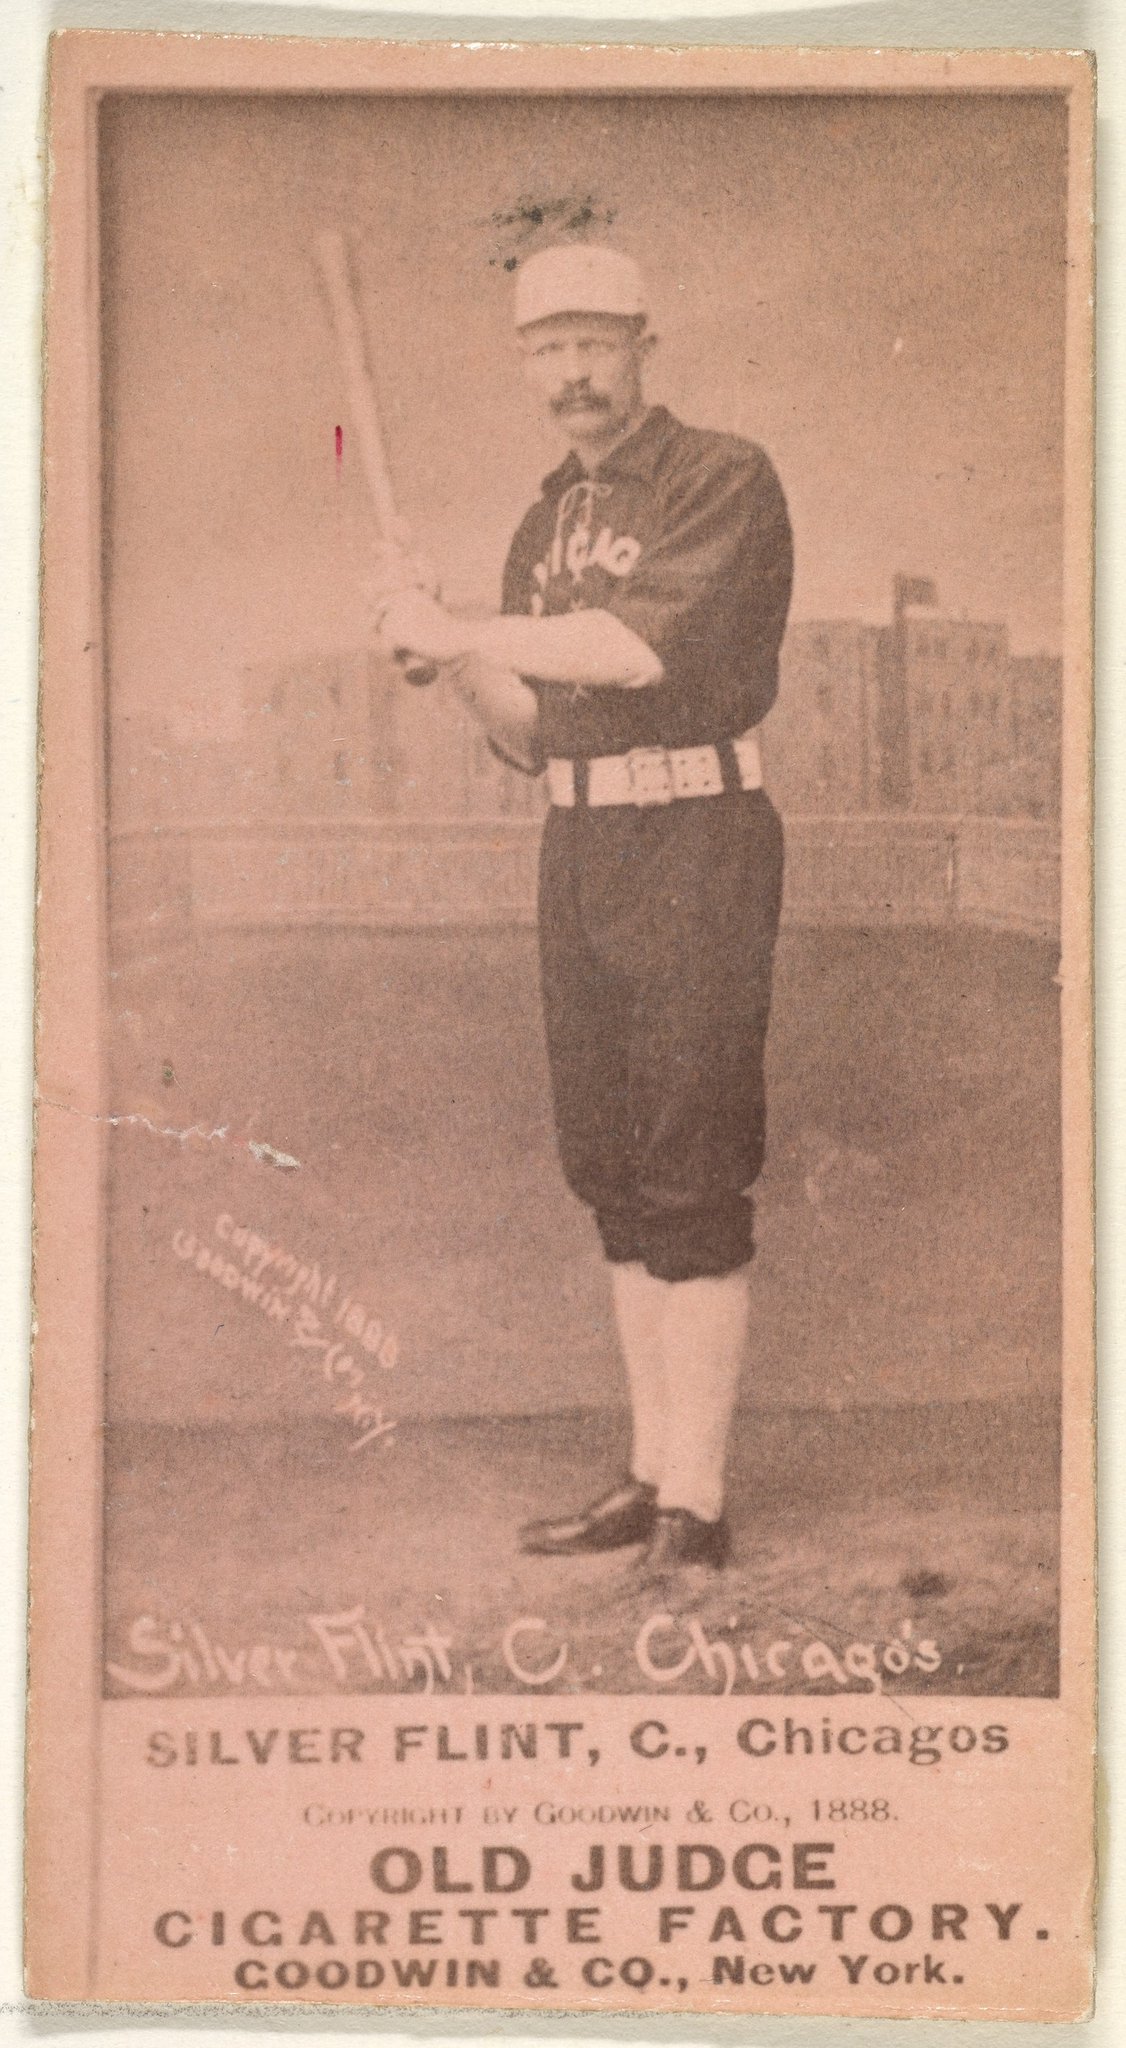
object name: baseball card, photograph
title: Frank Sylvester "Silver" Flint, Catcher, Chicago, from the Old Judge series (N172) for Old Judge Cigarettes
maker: goodwin & company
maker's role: publisher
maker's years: 1850-1950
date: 1888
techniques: albumen silver print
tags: men,portraits,baseball,athletes